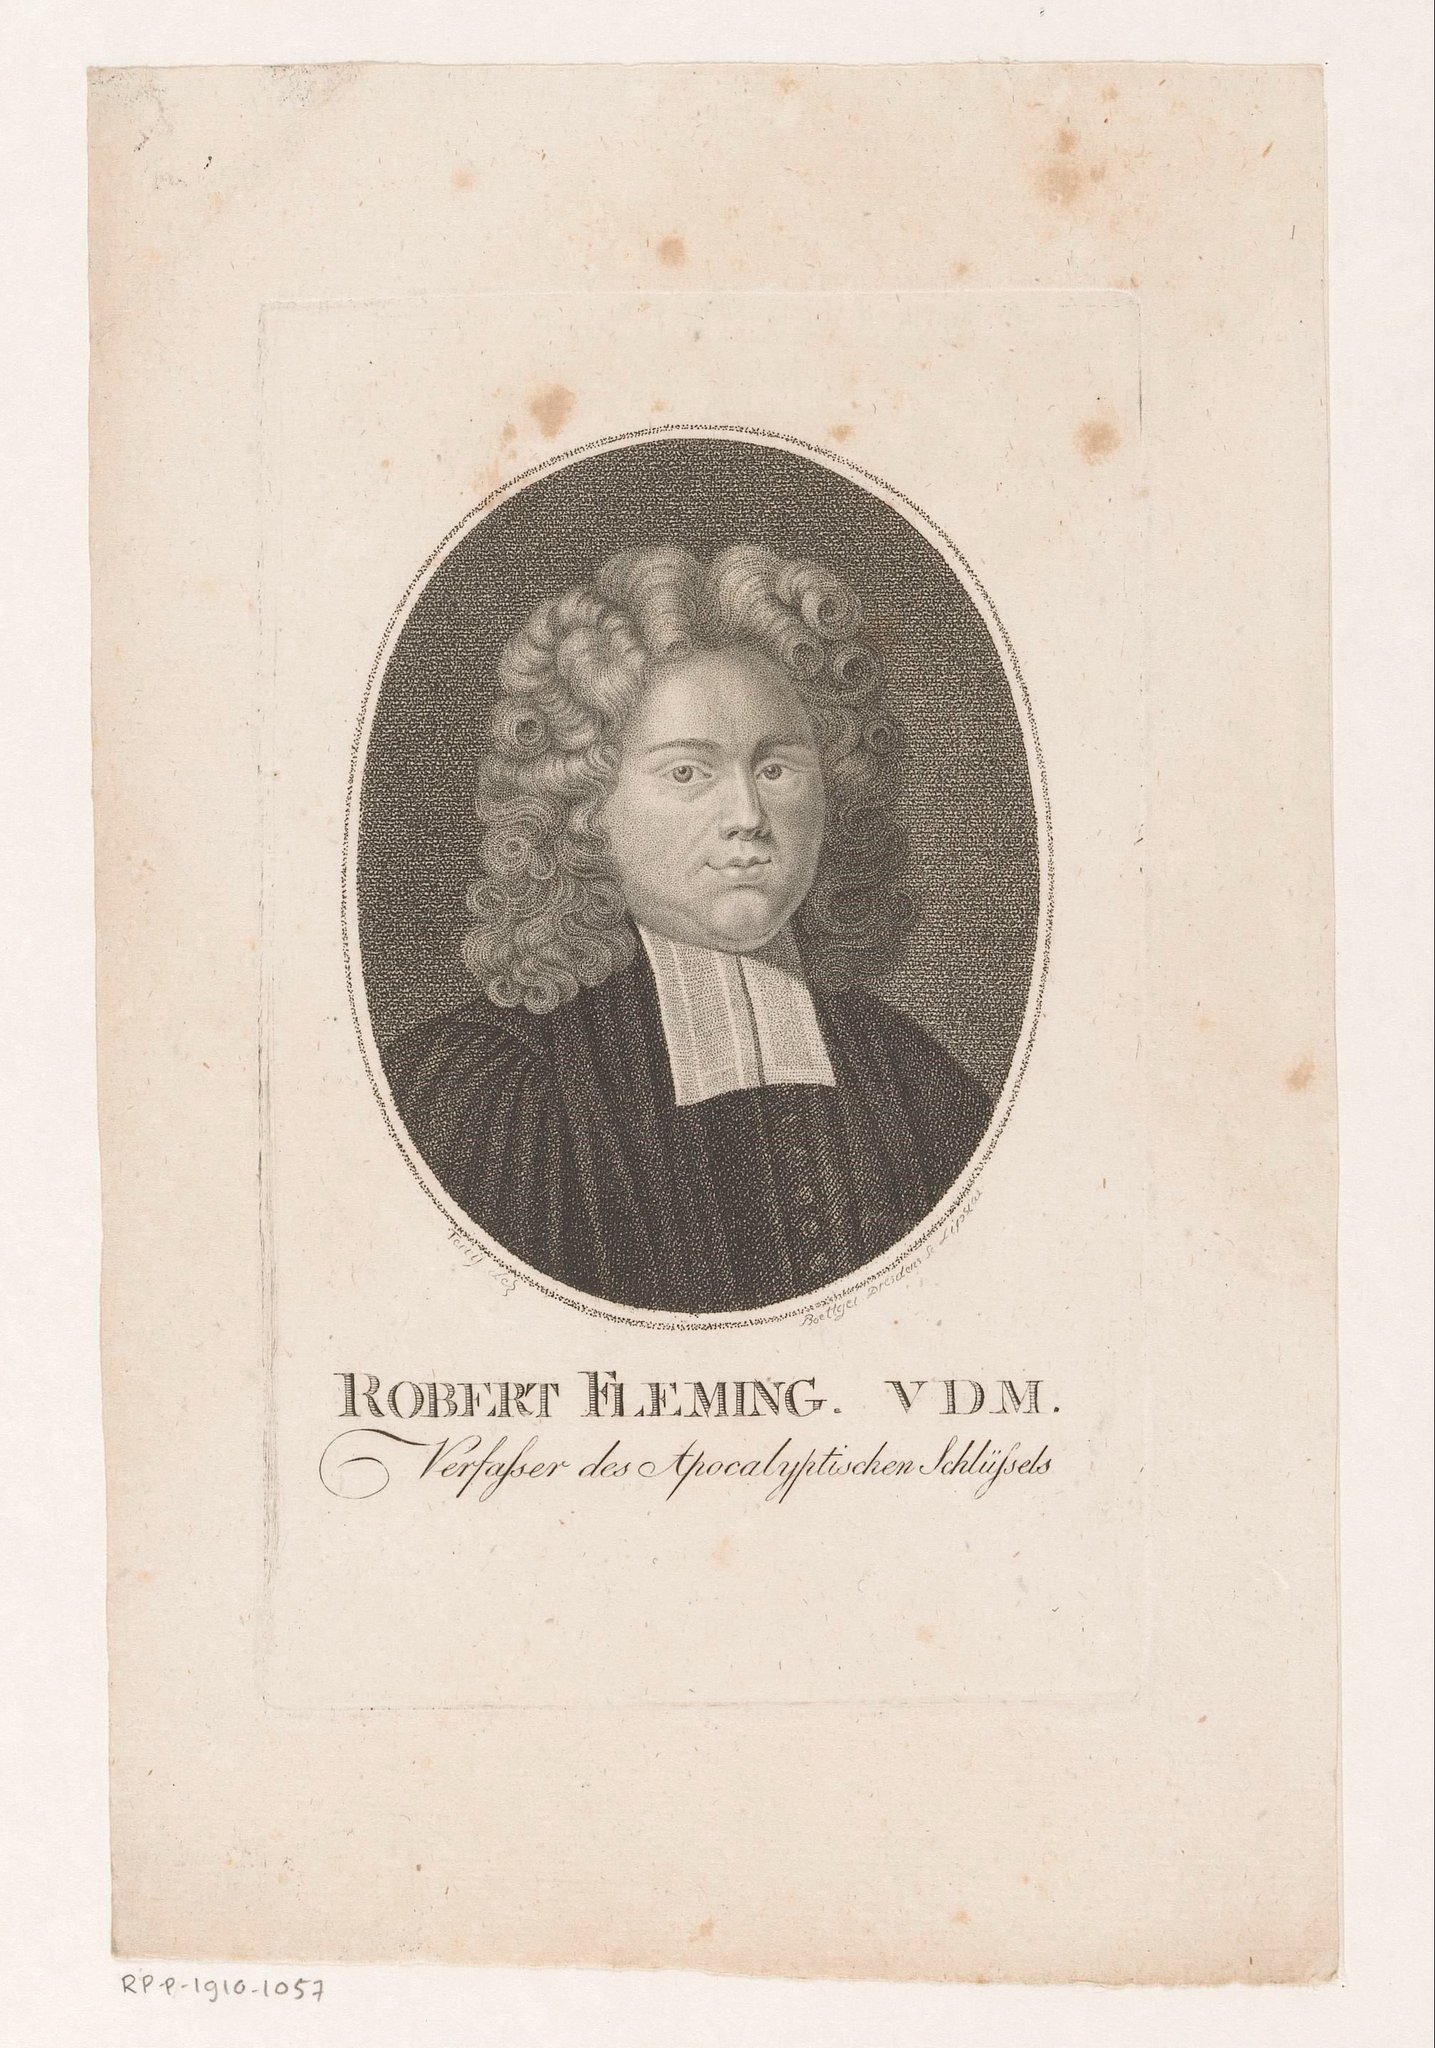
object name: print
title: Portret van Robert Fleming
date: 1796-1825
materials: paper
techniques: etching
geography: leipzig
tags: historical persons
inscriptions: collector's mark: Lugt 2228